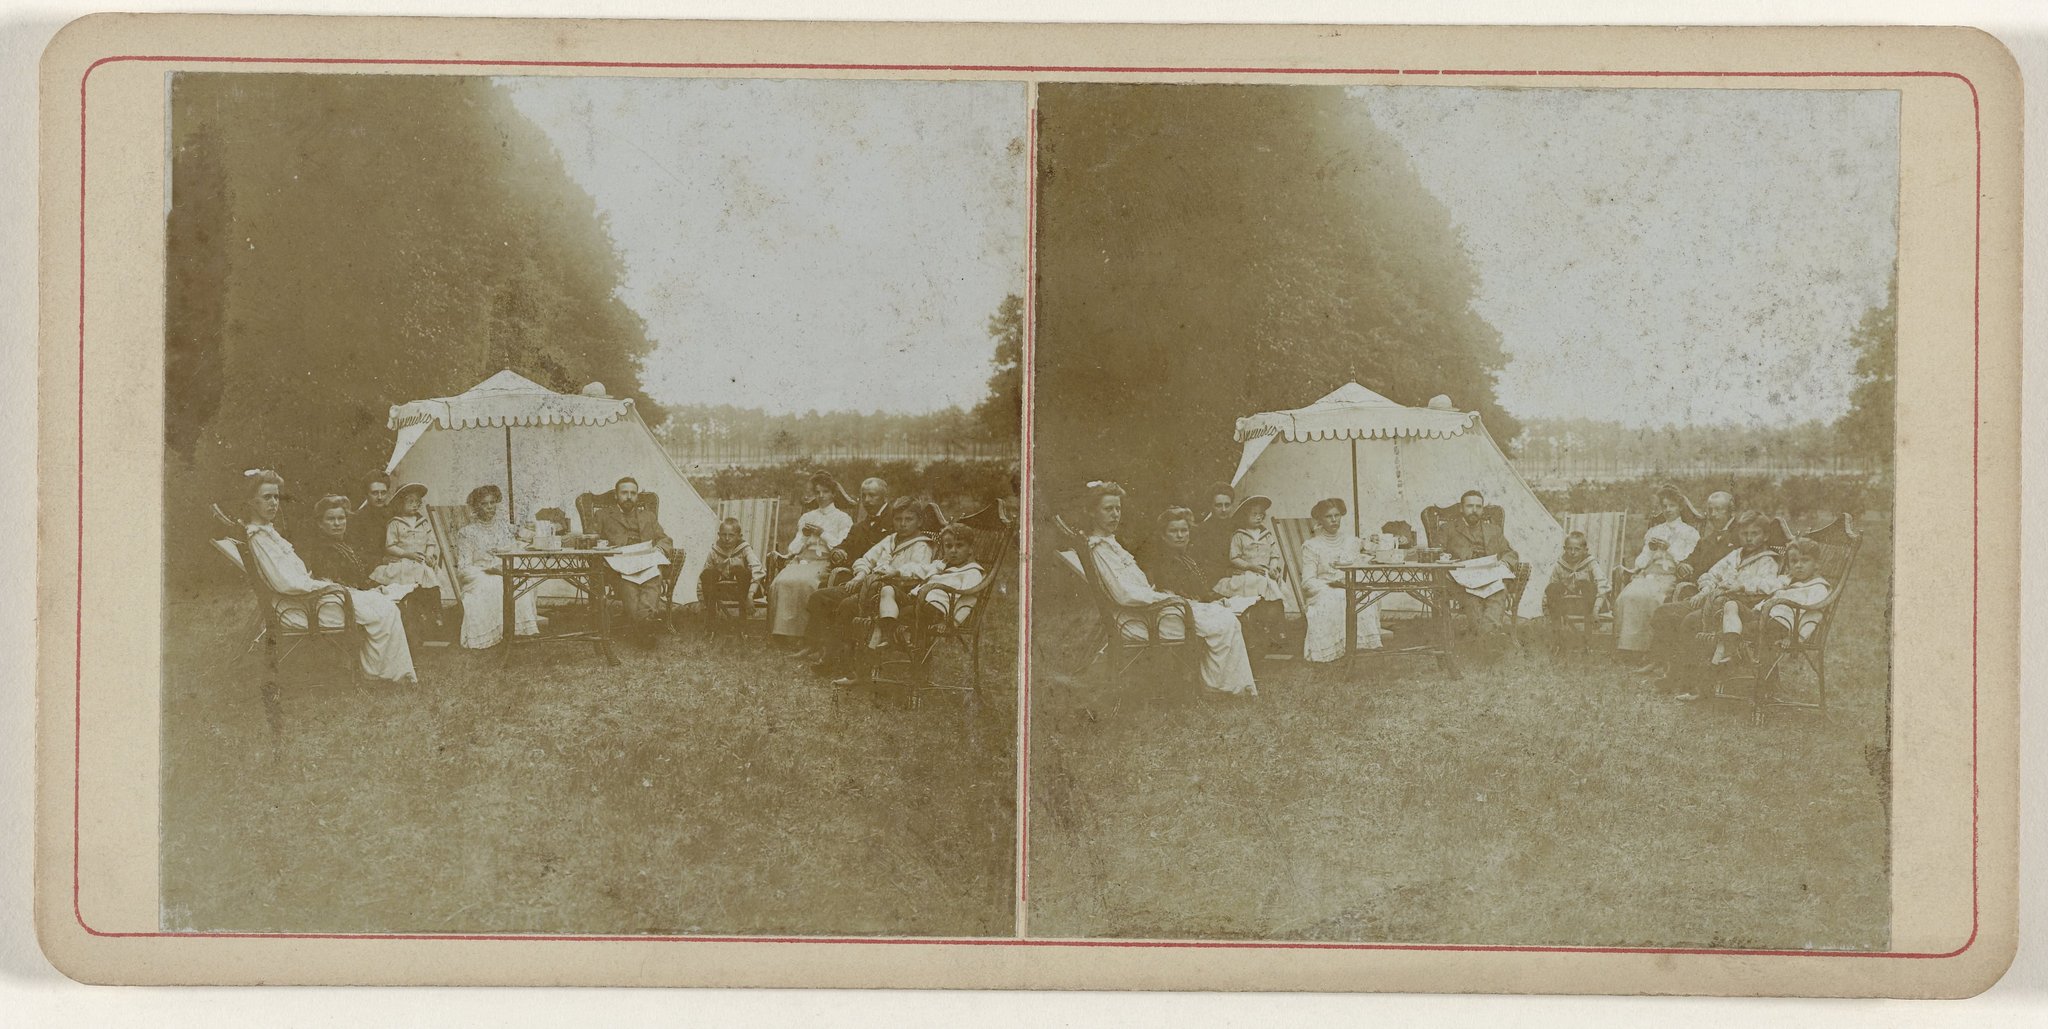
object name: stereograph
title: Familie Kessler tijdens een uitje op het landgoed van kasteel Ter Horst in Loenen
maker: geldolph adriaan kessler (dolph)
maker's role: fotograaf, industrieel, voetballer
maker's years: 1884-1945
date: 1904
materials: paper, photographic support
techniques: collodion silver print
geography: potsdam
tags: loenen